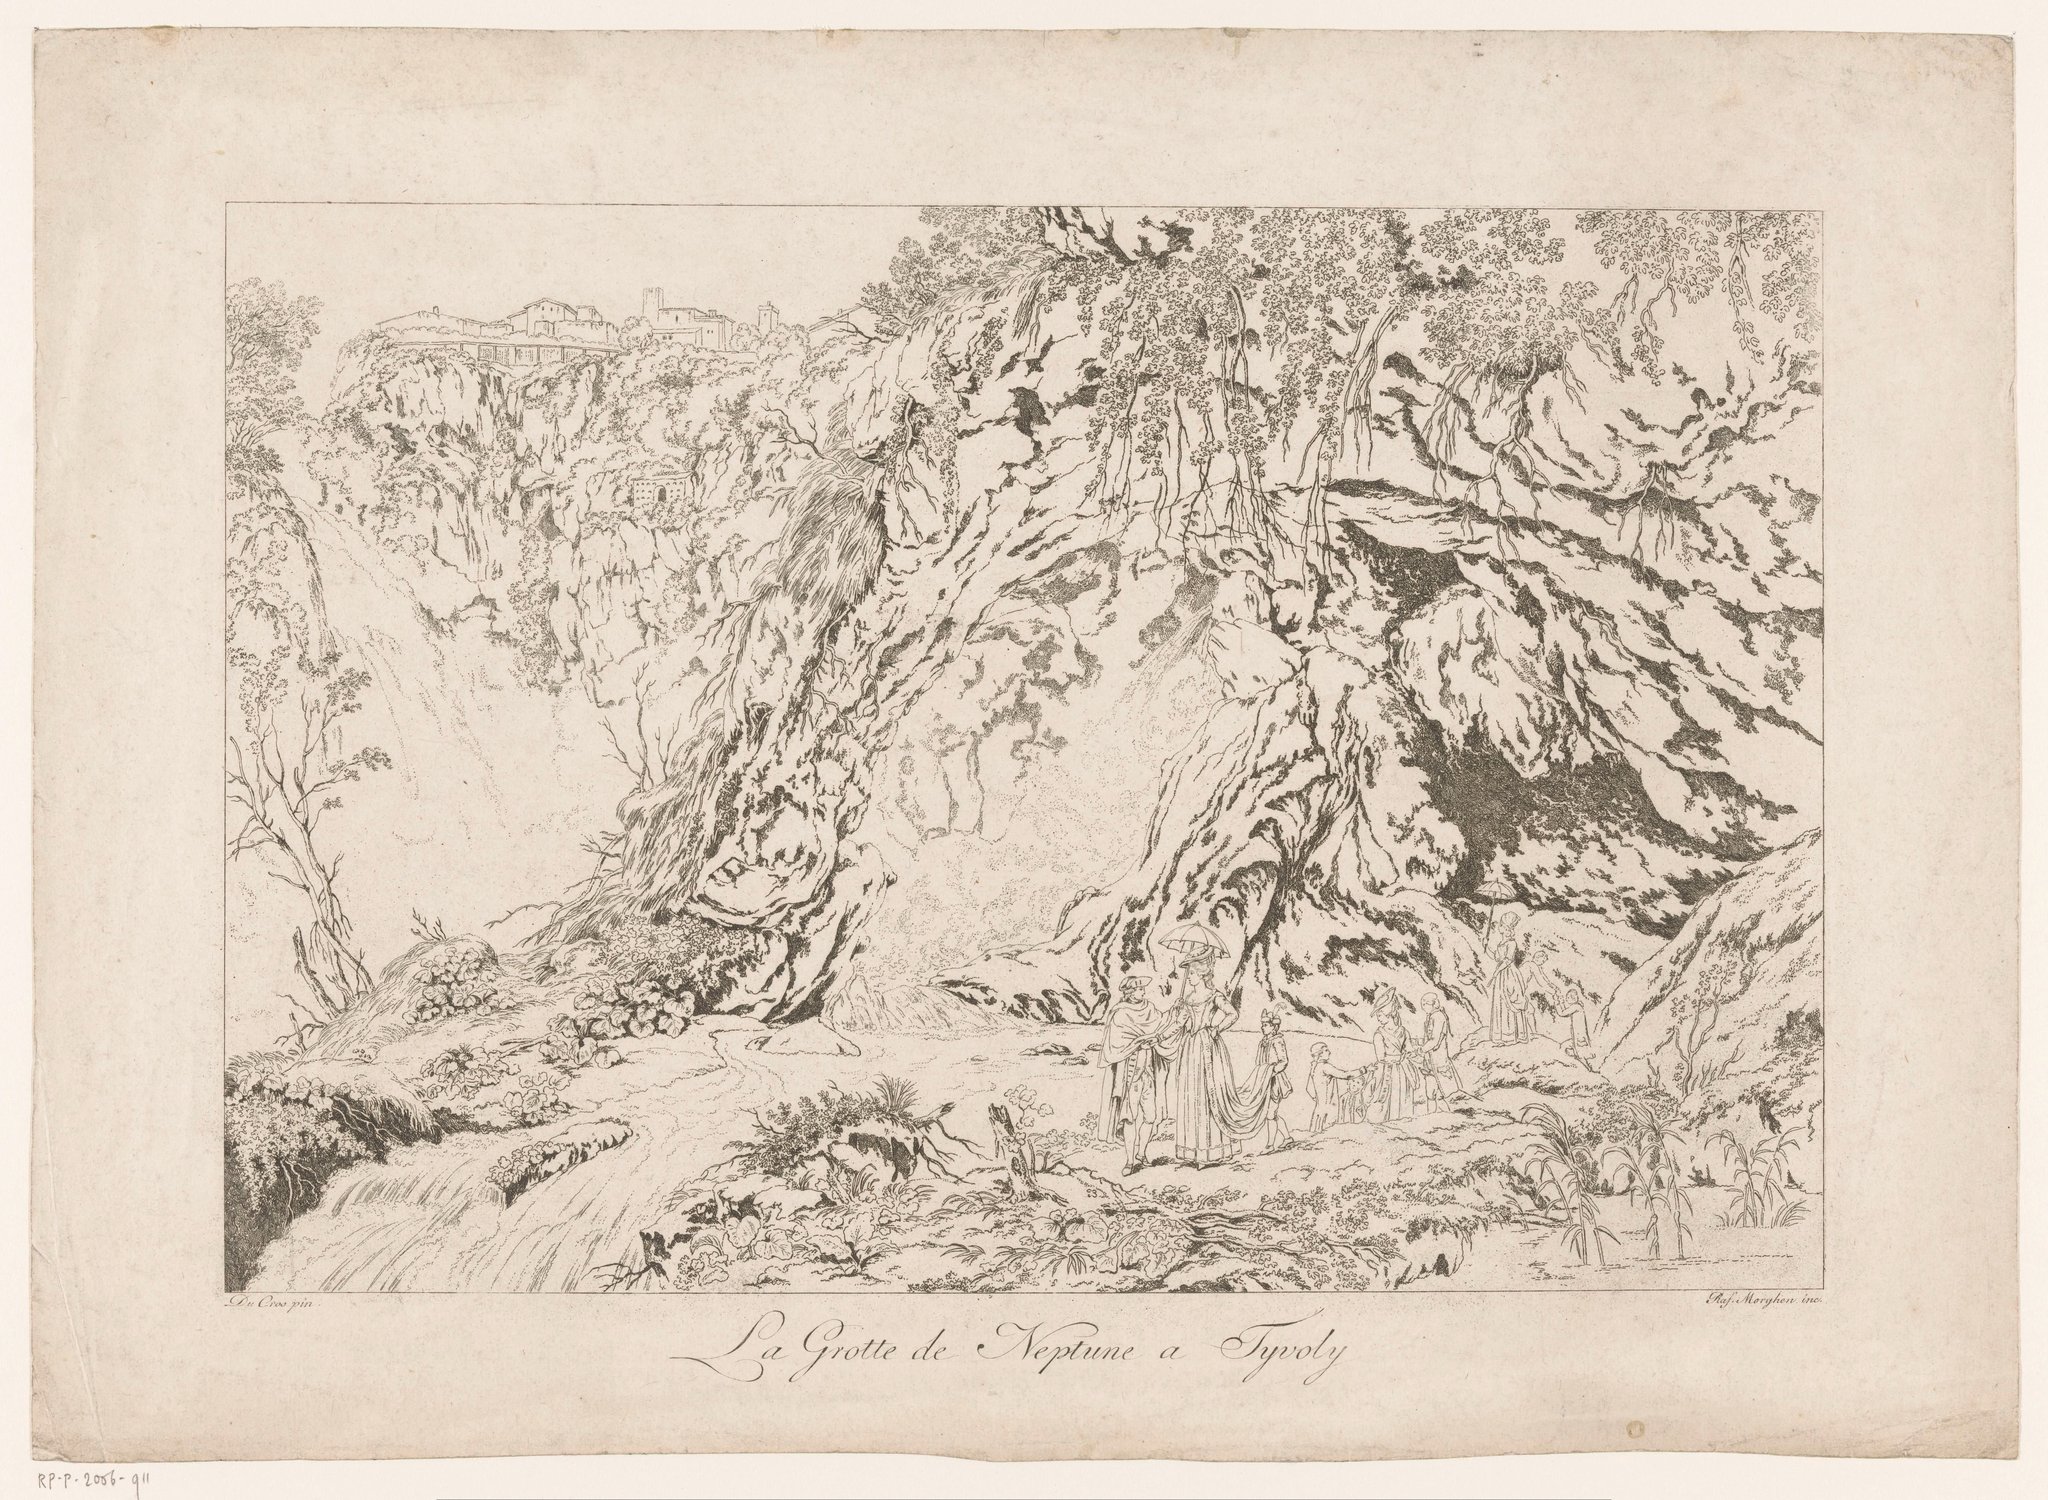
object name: print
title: La Grotte de Neptune a Tyvoly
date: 1768-1833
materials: paper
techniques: etching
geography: italy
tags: landscapes, waterfall, tivoli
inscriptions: collector's mark: ‘V E’, collector's mark: Lugt 2228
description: Een elegant gezelschap wandelt langs een waterval in een landschap met hoge rotsen te Tivoli. Op de achtergrond links een tweede waterval en een stad bovenop de rotsen.